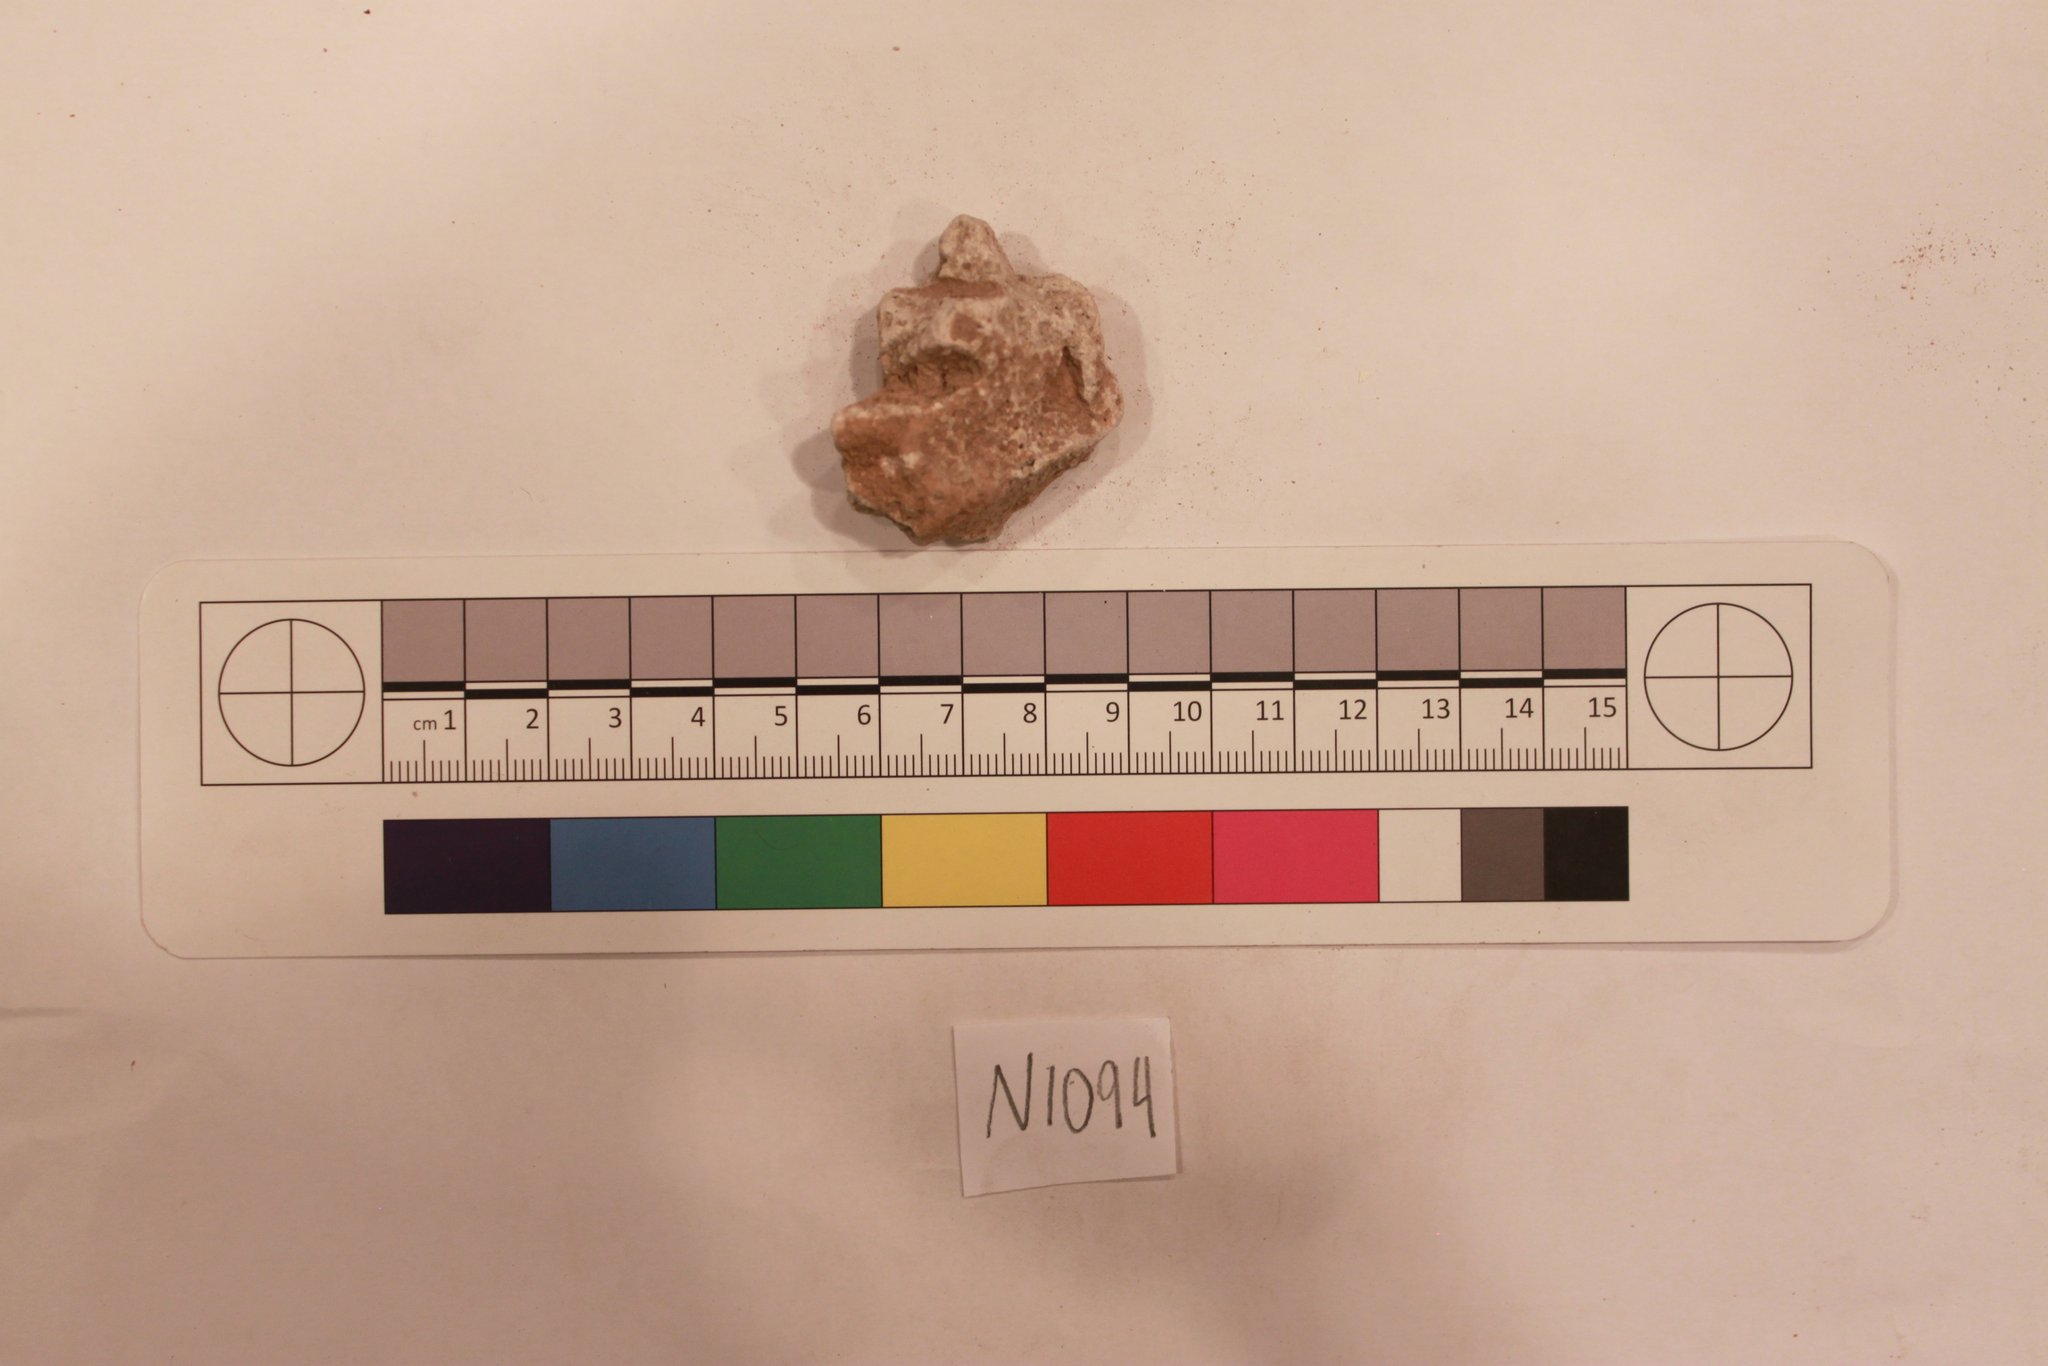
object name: fragment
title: Stucco Fragment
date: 701-1200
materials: plaster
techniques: carving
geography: iran